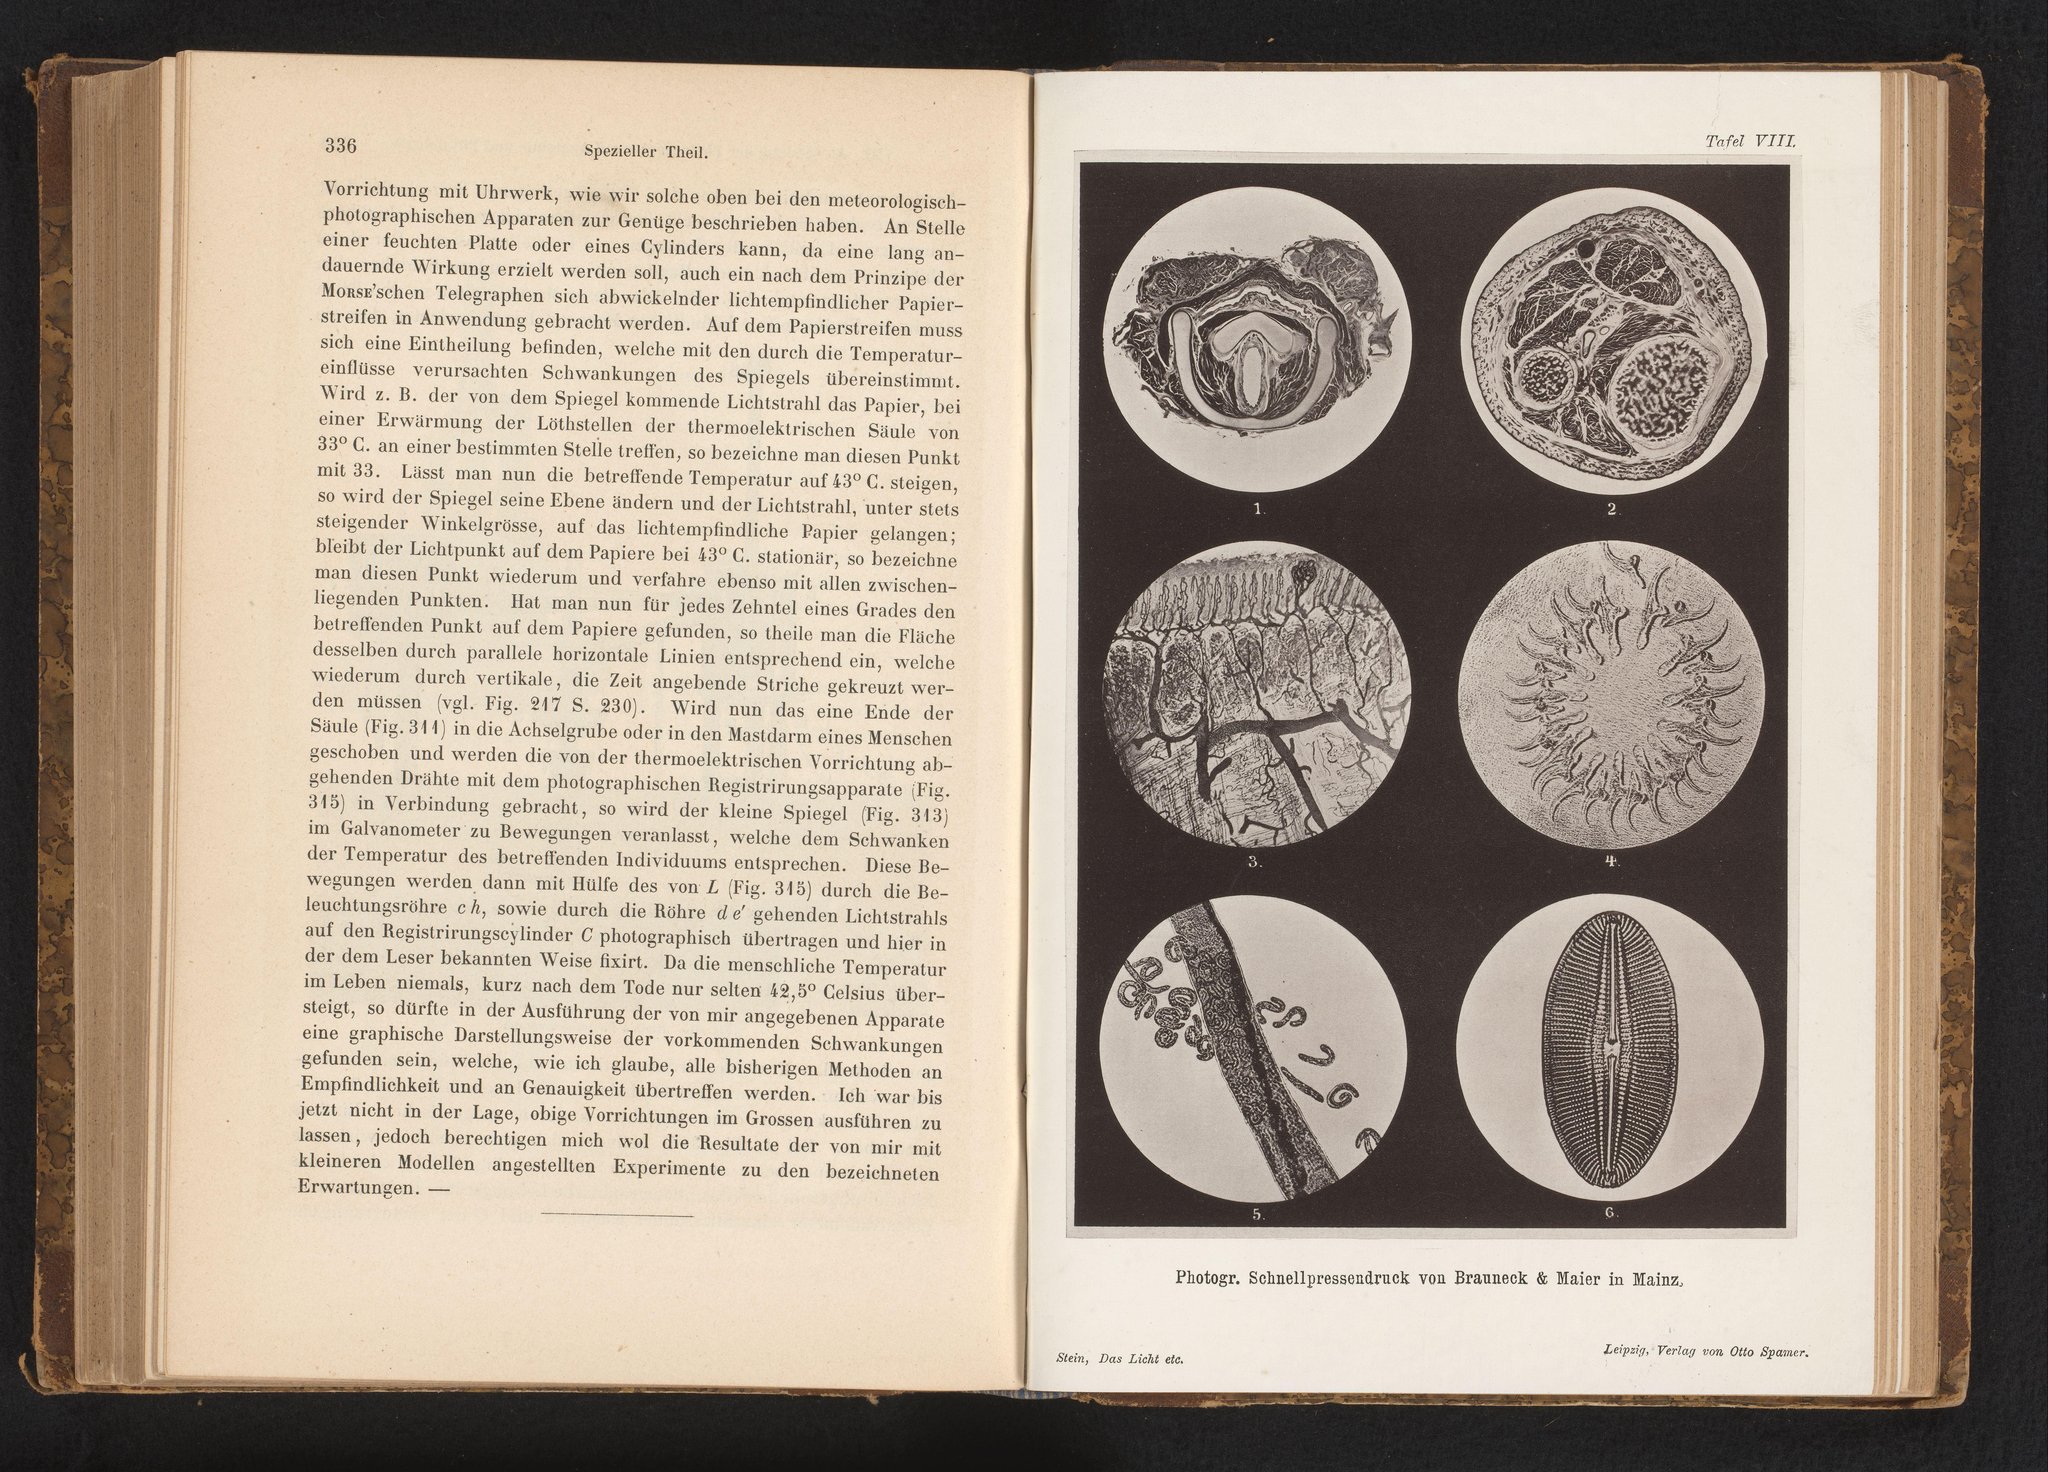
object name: page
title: Zes microscopische vergrotingen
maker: Anonymous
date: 1867-1877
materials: paper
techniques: photograph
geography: mainz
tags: anatomy (non-medical), microscope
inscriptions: number: ‘Tafel VIII.’